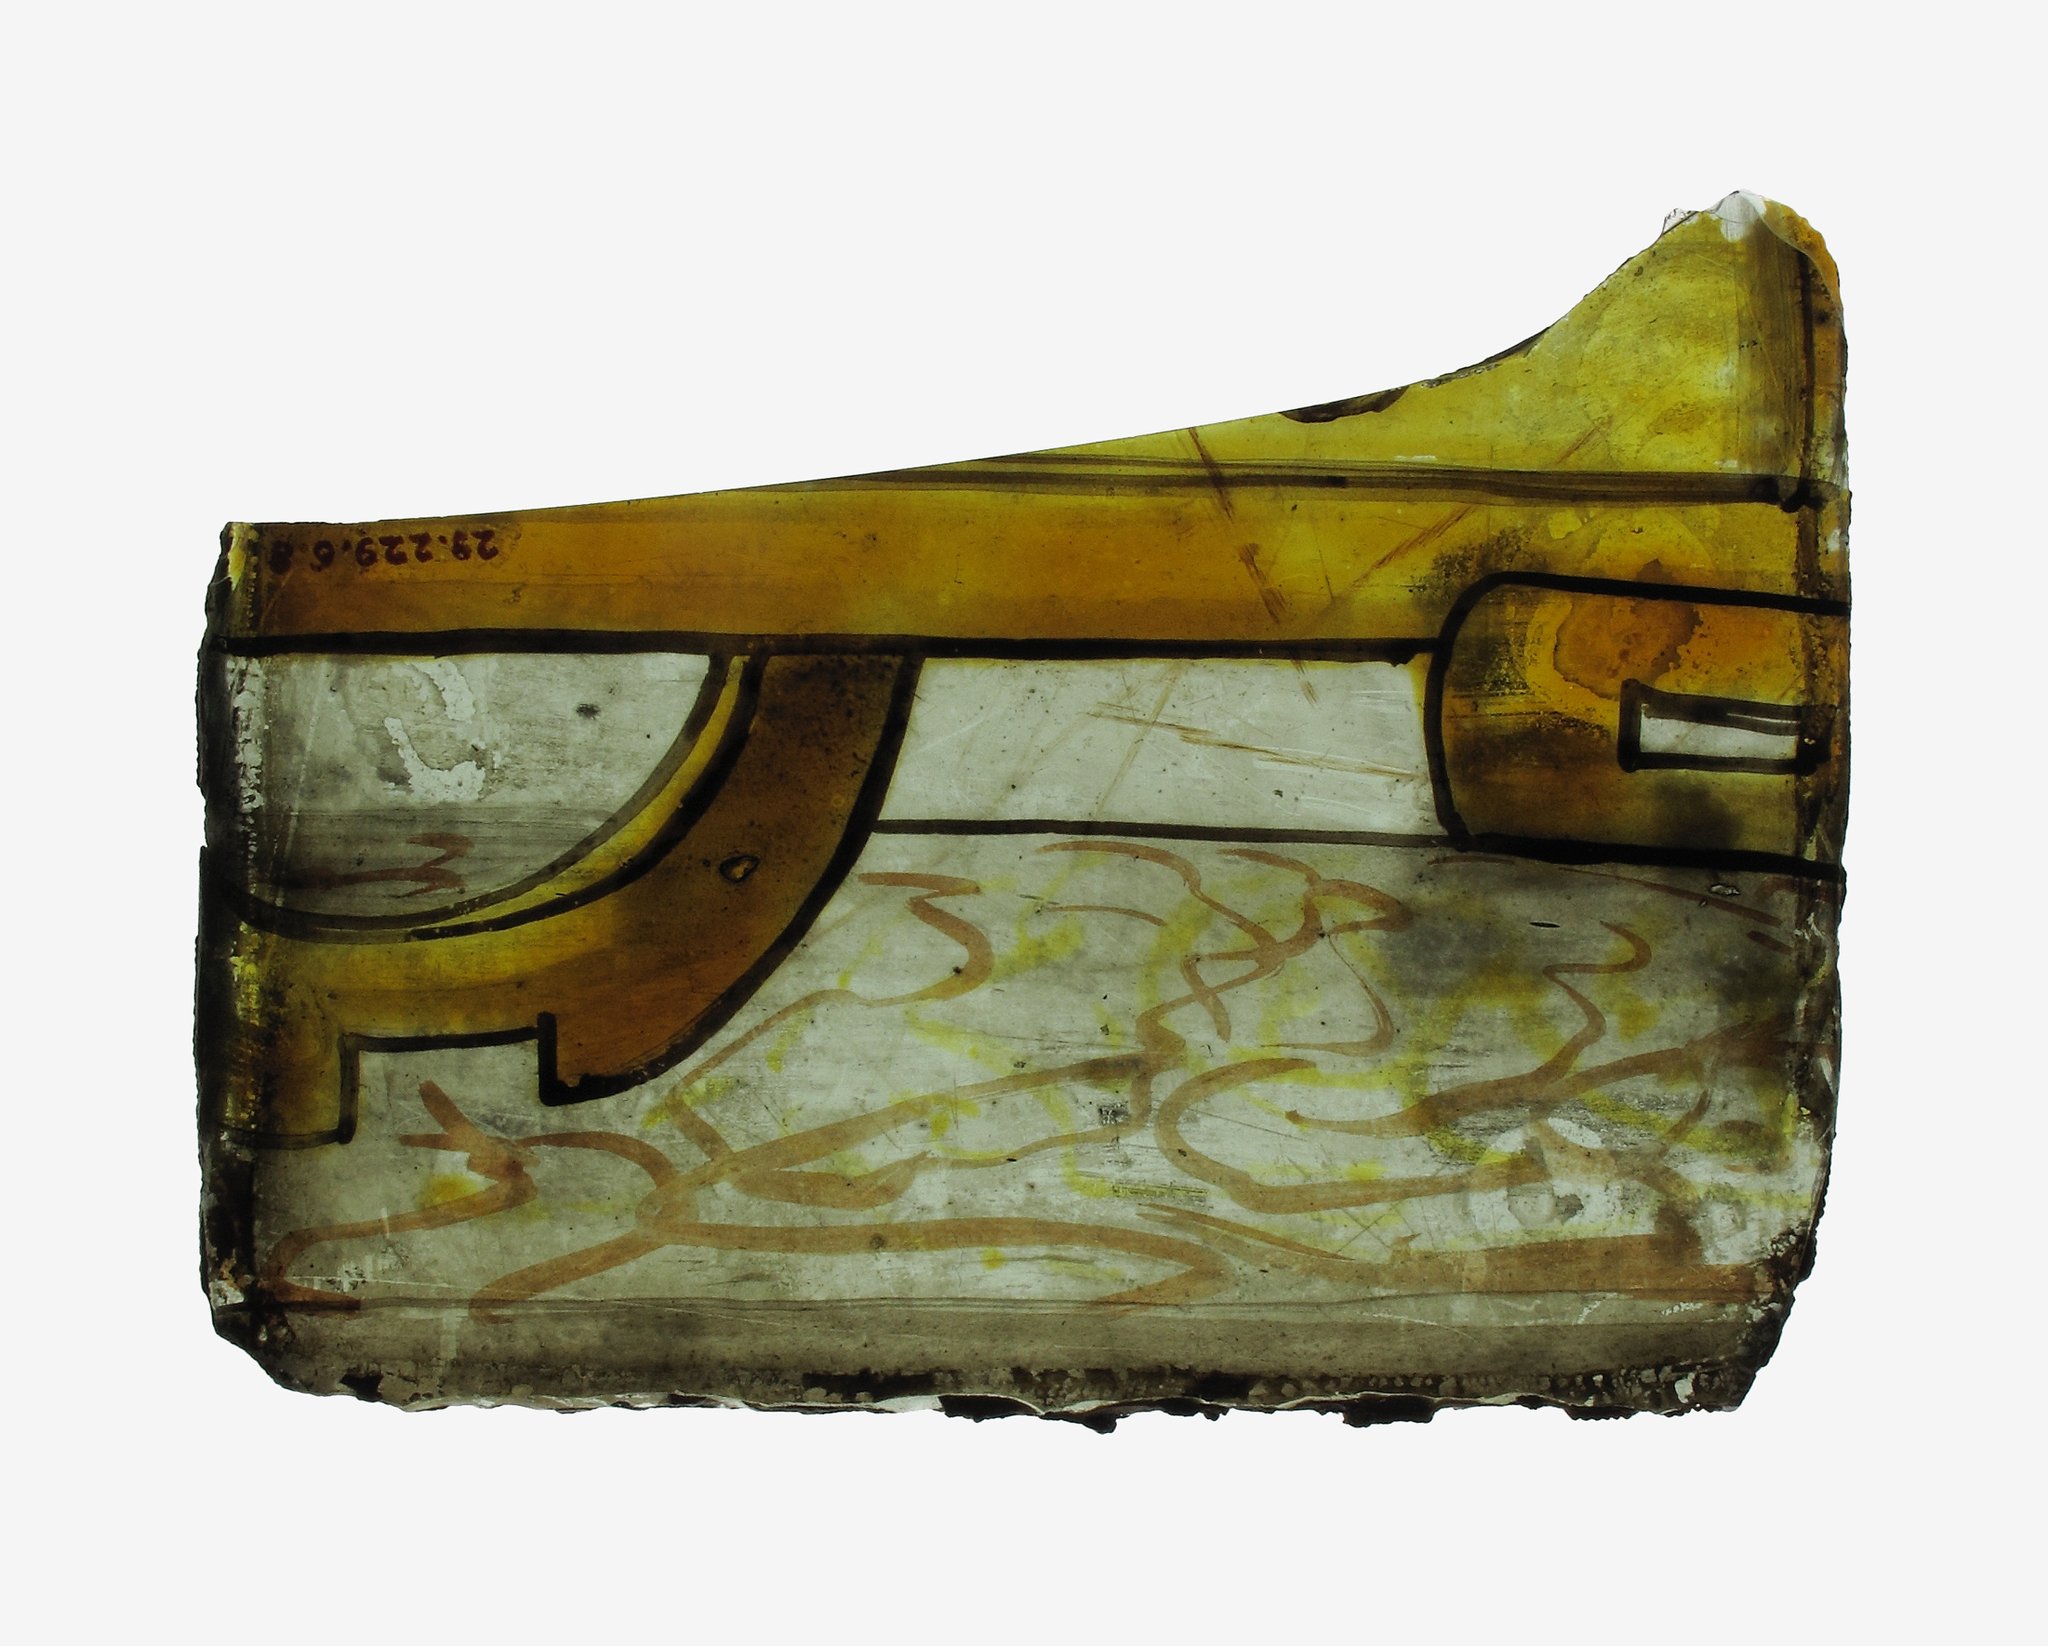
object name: fragment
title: Glass Fragment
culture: south netherlandish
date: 1501-1600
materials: glass, lead